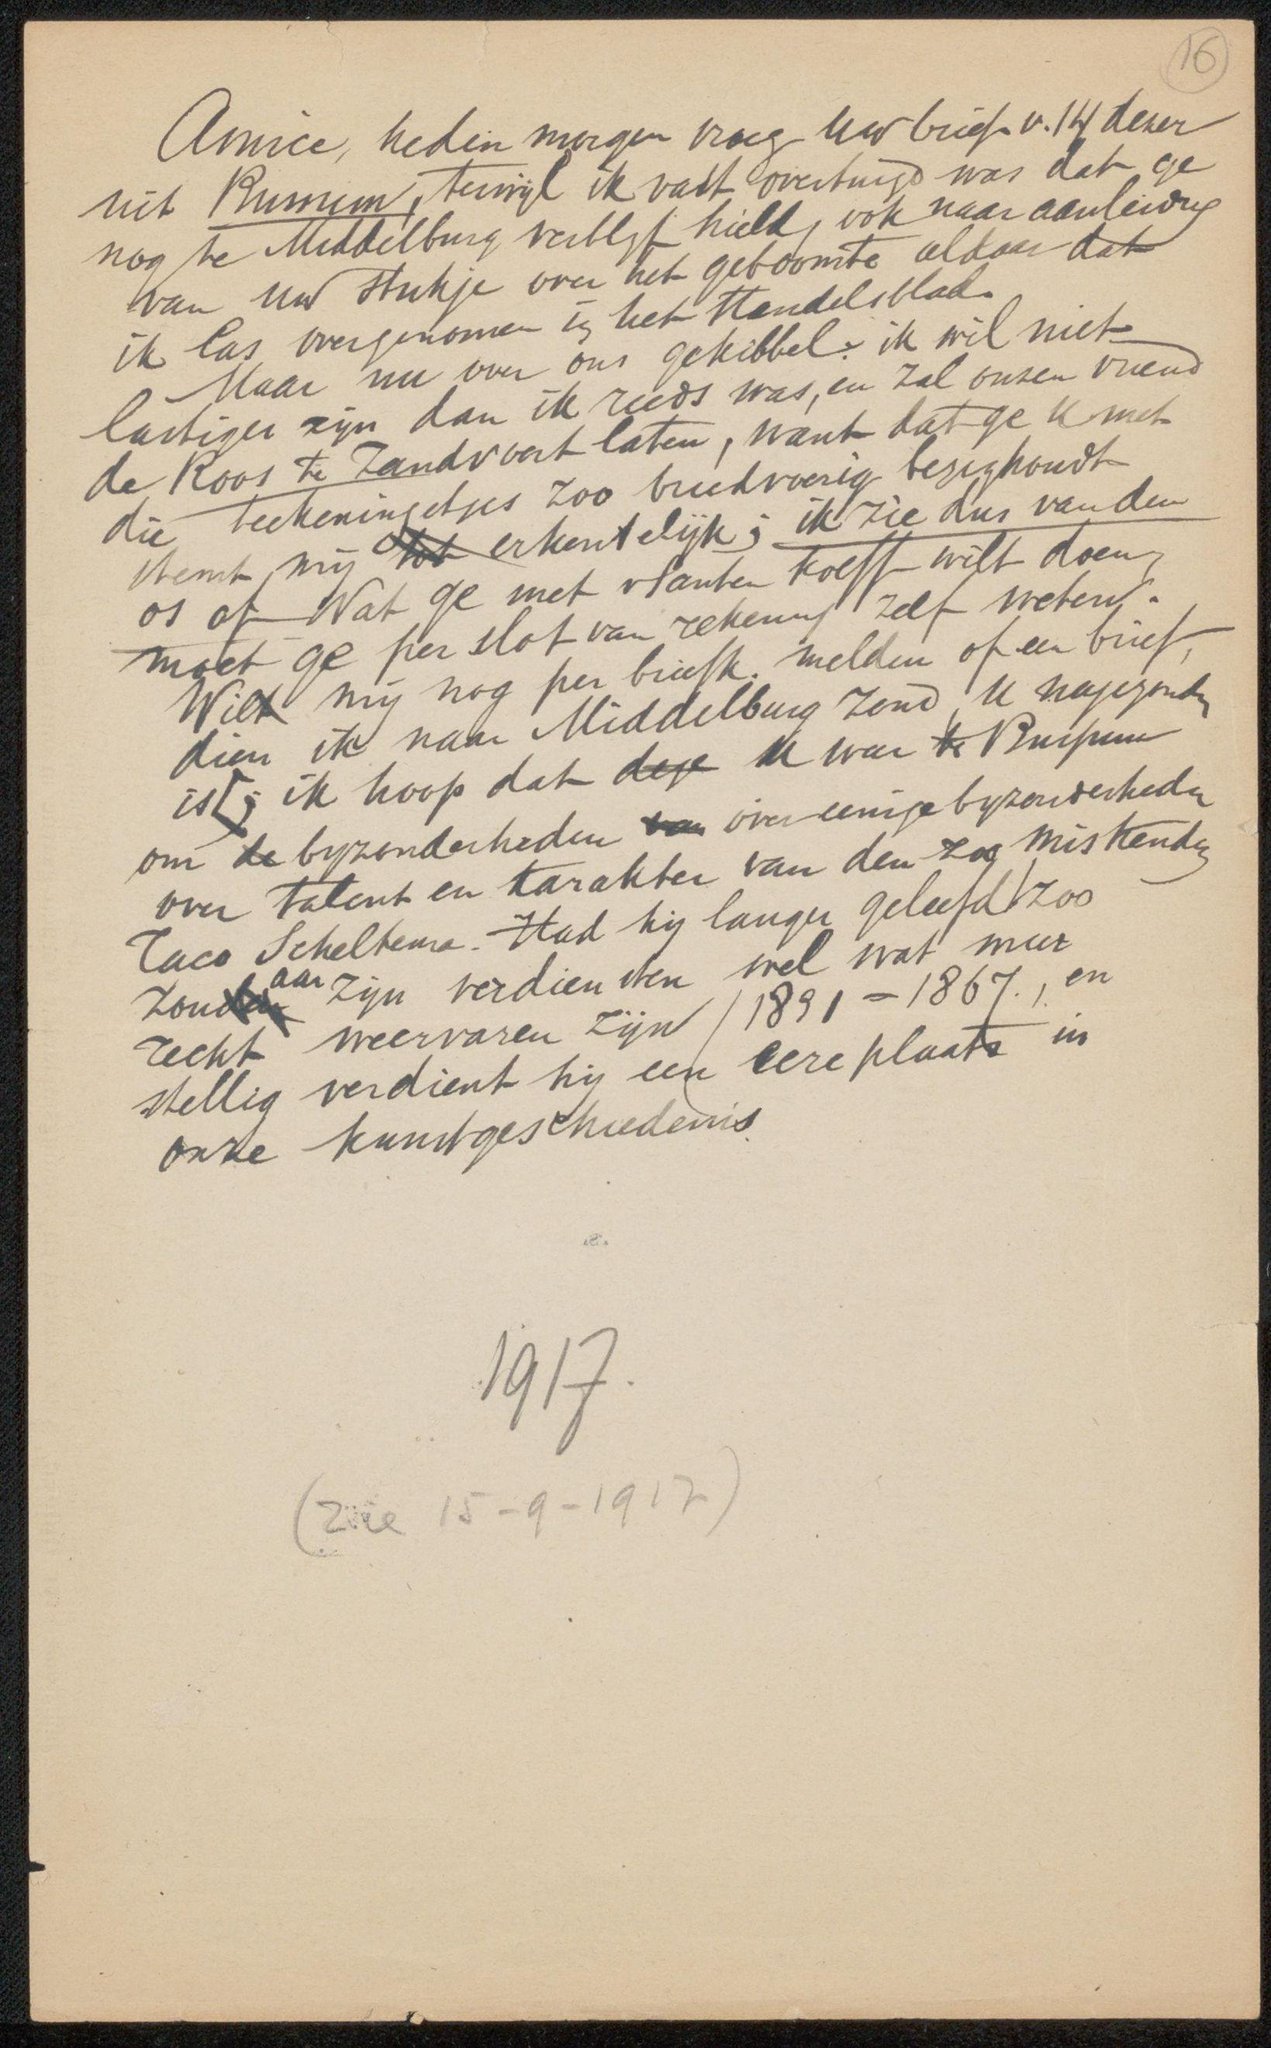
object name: letter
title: Brief aan Jan Veth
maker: august allebé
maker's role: draughtsman, print maker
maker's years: 1838-1927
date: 1848-1927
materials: ink, paper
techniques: pen, printing, writing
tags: jan veth, haarlem, print maker, draughtsman, sjoerd hendrik de roos, taco jan scheltema, rotterdam, painter, middelburg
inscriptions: collector's mark: ‘RPK’